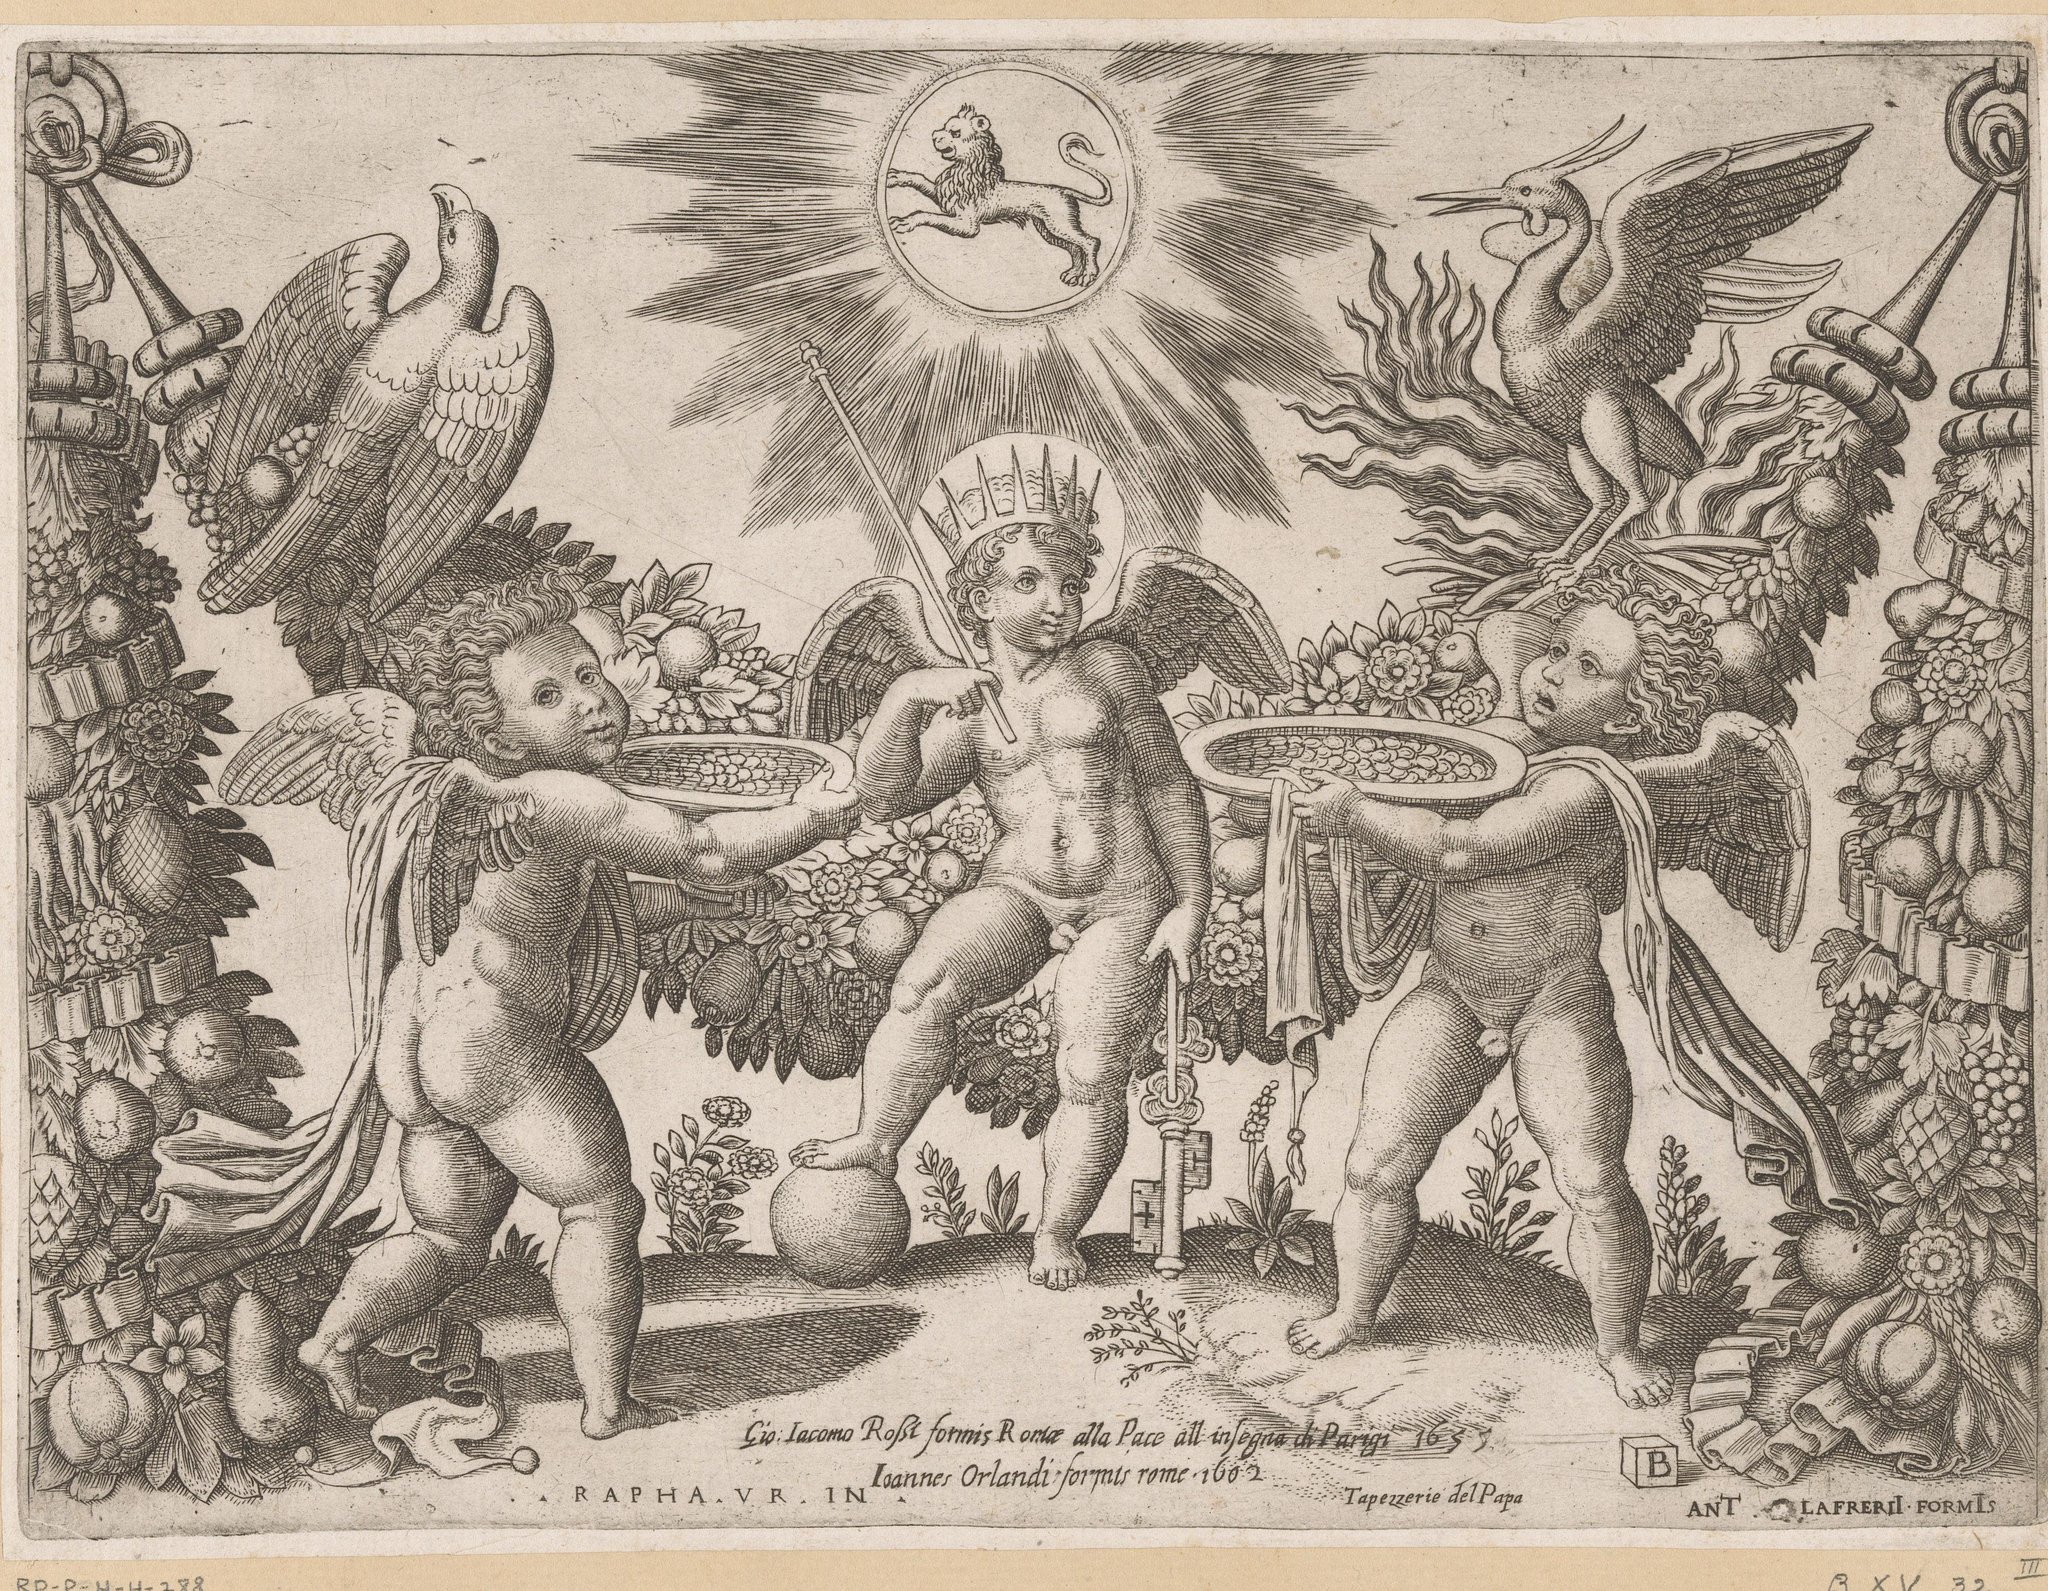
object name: print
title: Tapezzerie de Papa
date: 1602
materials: paper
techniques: engraving, intaglio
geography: italy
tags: coin, beasts of prey, predatory animals: lion, cupids: 'amores', 'amoretti', 'putti'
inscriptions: collector's mark: Lugt 10, collector's mark: ‘Hinloopen’, collector's mark: Lugt 11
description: Voor een grote guirlande staan drie putti. De middelste putto draagt een kroon en staat met één voet op een bol. In zijn handen houdt hij een staf en sleutels. Links en rechts putti met schalen gevuld met munten. Boven hen twee vogels en een leeuw in een cirkel.